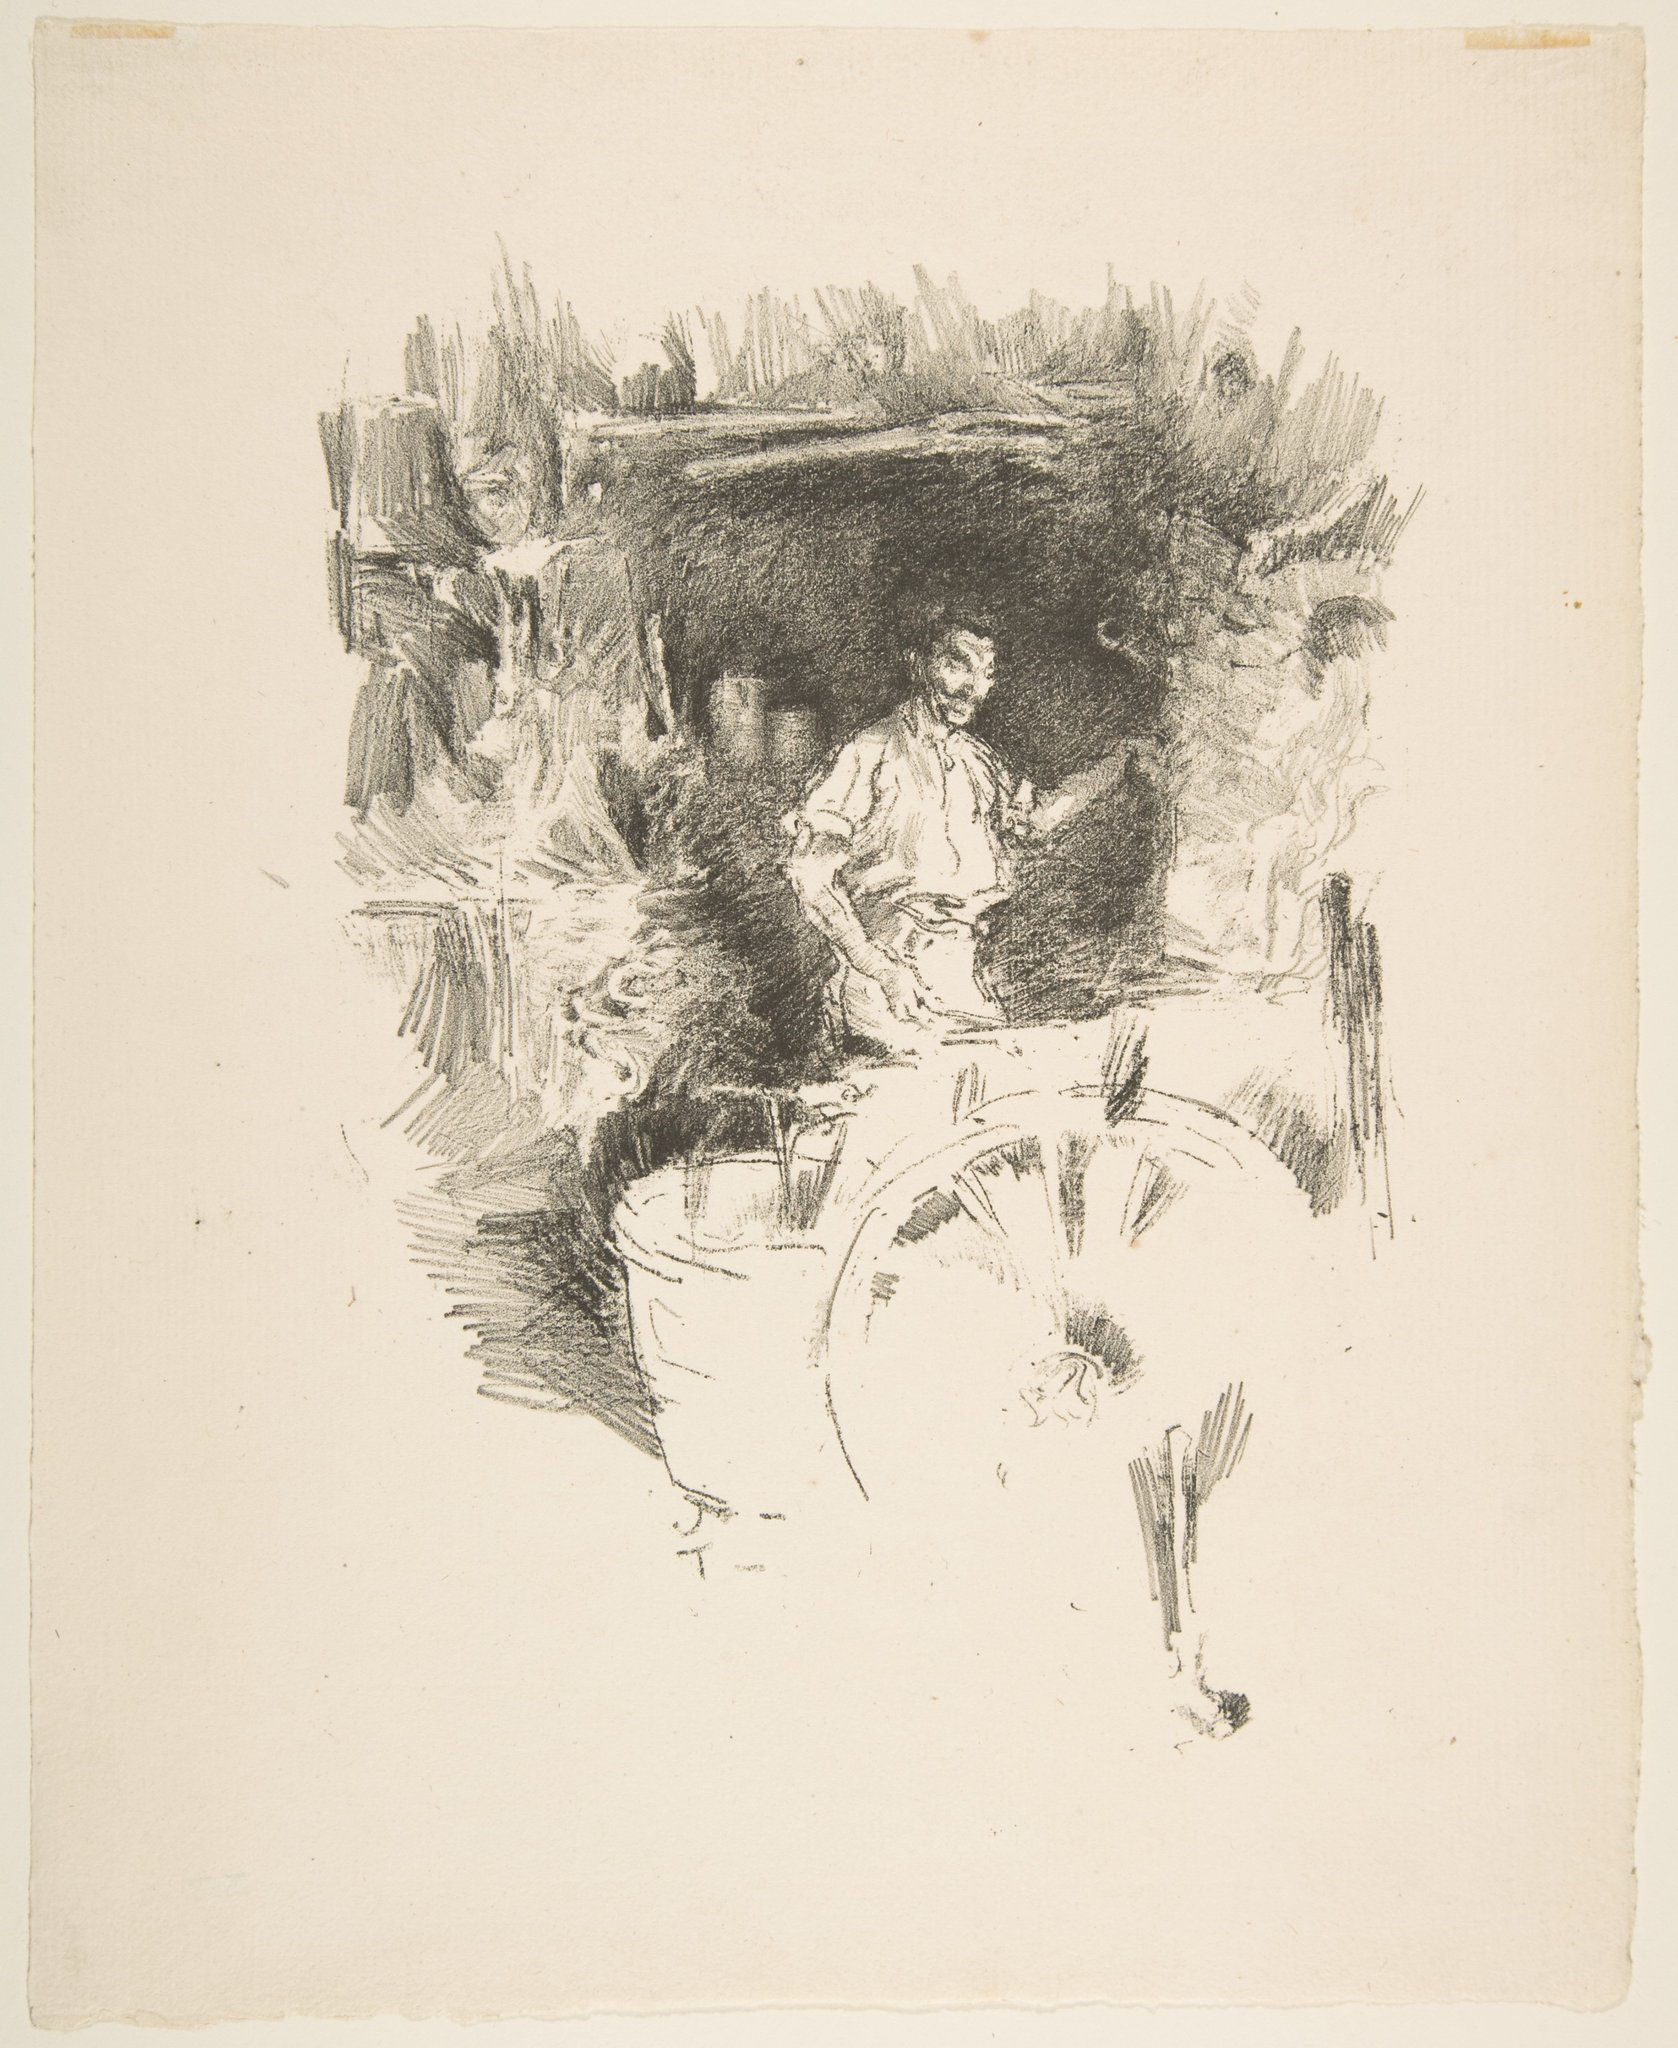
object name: print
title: The Blacksmith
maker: james mcneill whistler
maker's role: artist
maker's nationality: american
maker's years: 1834-1903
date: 1895-1896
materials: ink, paper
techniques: printing, stumping, lithography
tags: men,working,blacksmiths